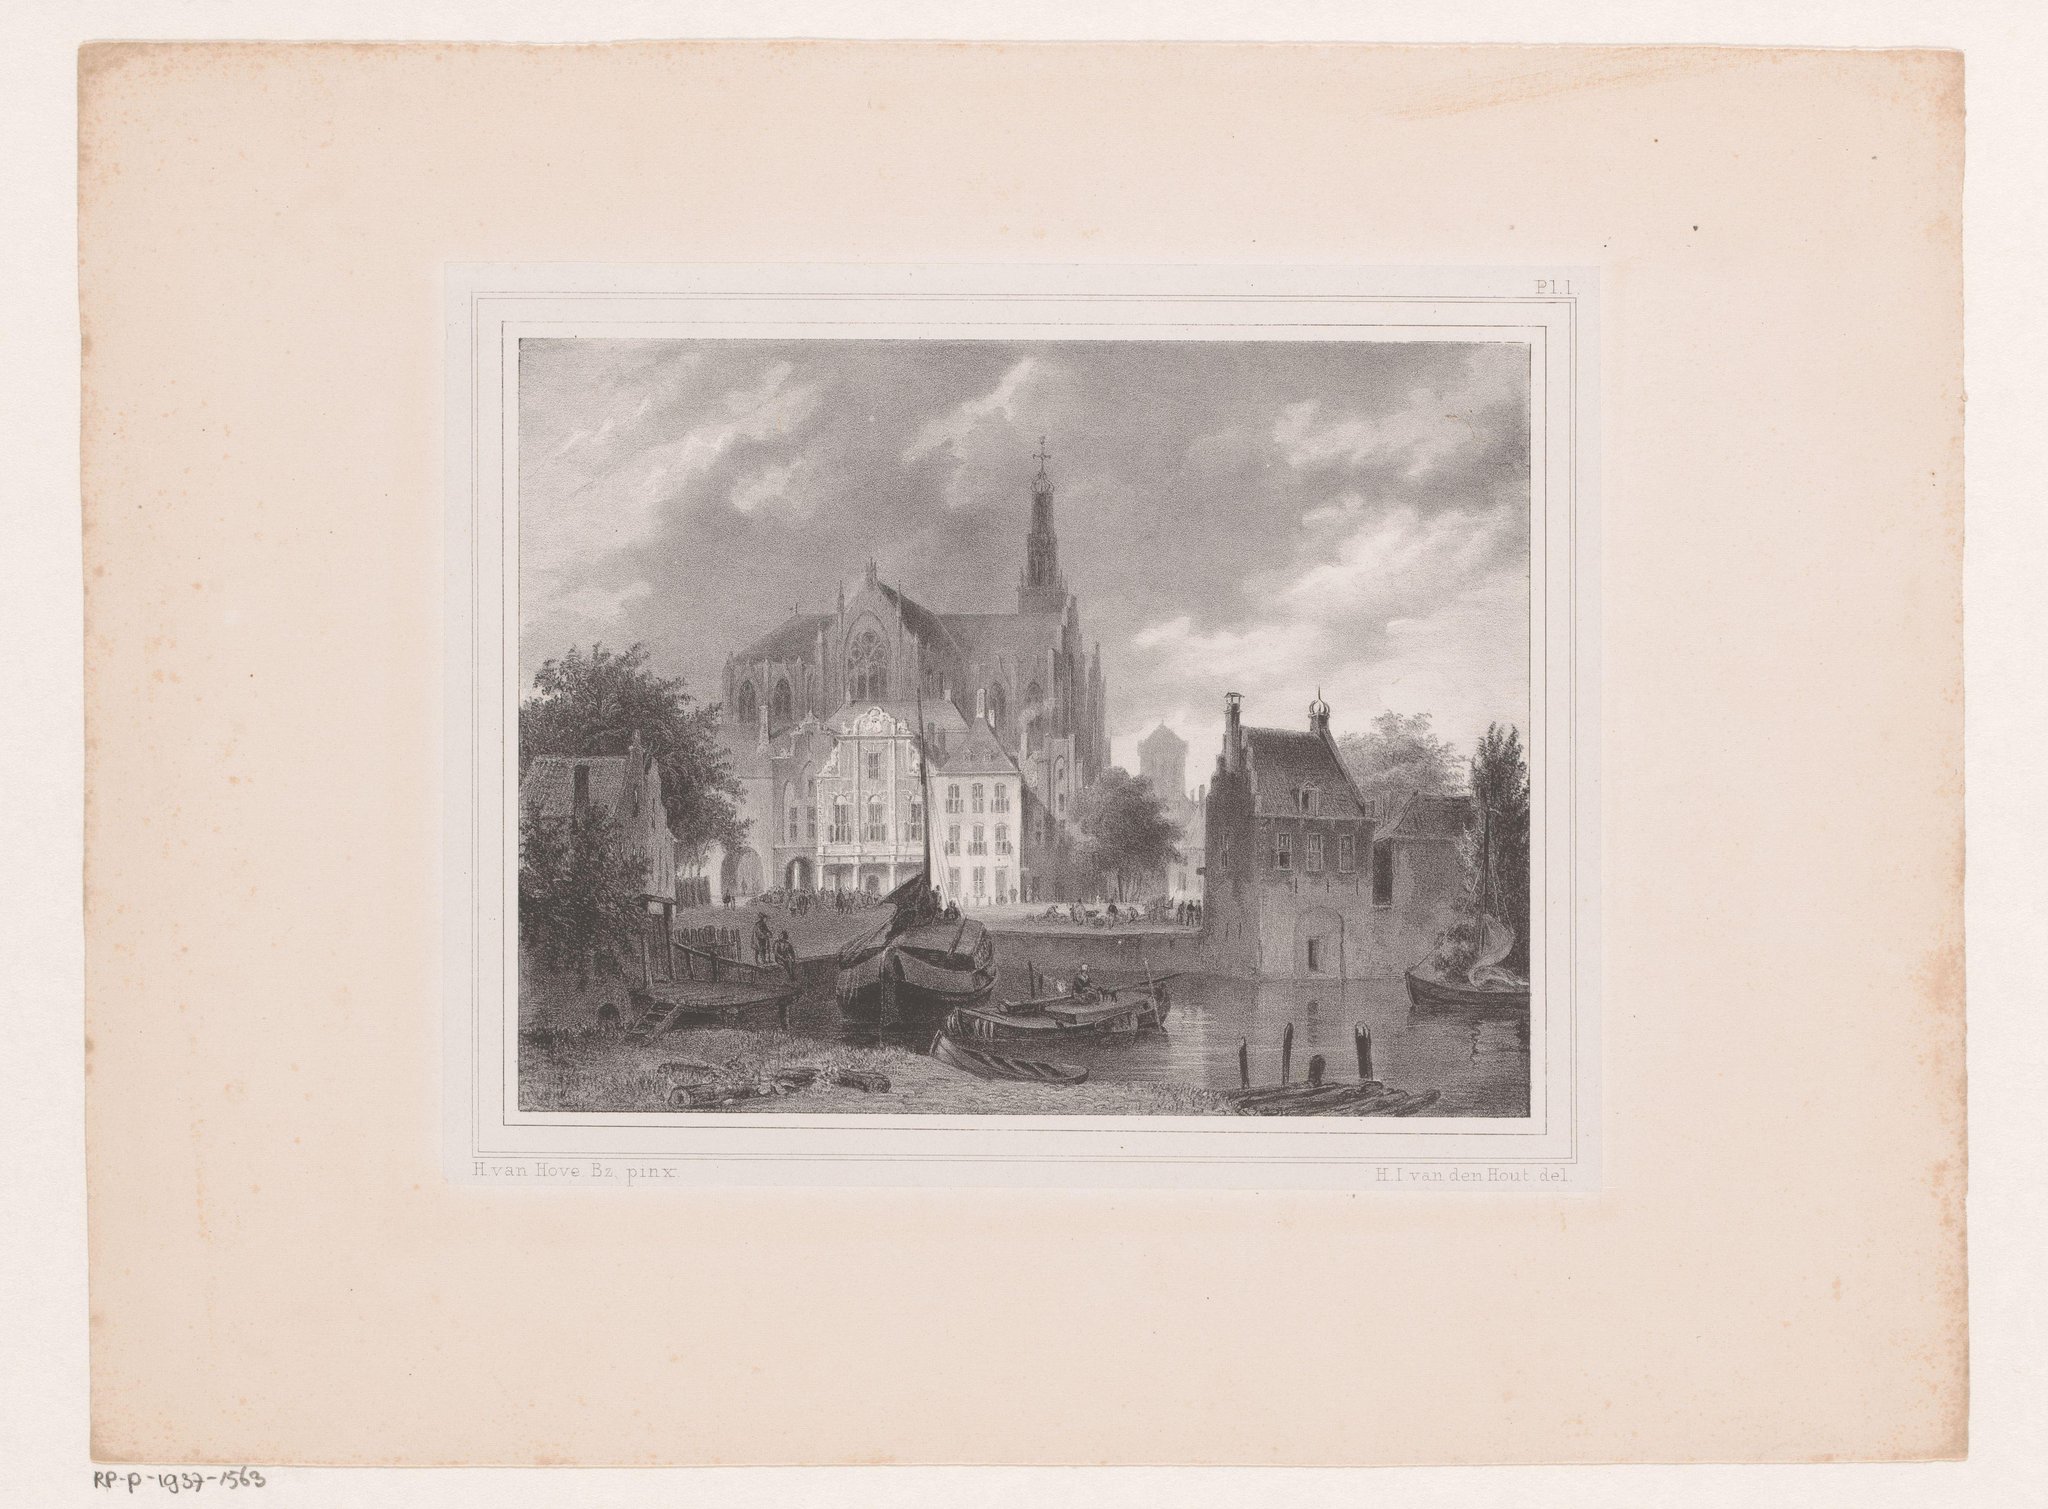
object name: print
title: Stadsgezicht met kerk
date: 1823-1869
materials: paper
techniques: lithograph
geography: netherlands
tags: sailing-ship, sailing-boat, church (exterior), rowing-boat, canoe, etc., city-view, and landscape with man-made constructions (+ city(-scape) with figures, staffage)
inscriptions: collector's mark: Lugt 2228, collector's mark: Lugt 2760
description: In de voorgrond liggen boten in het water.